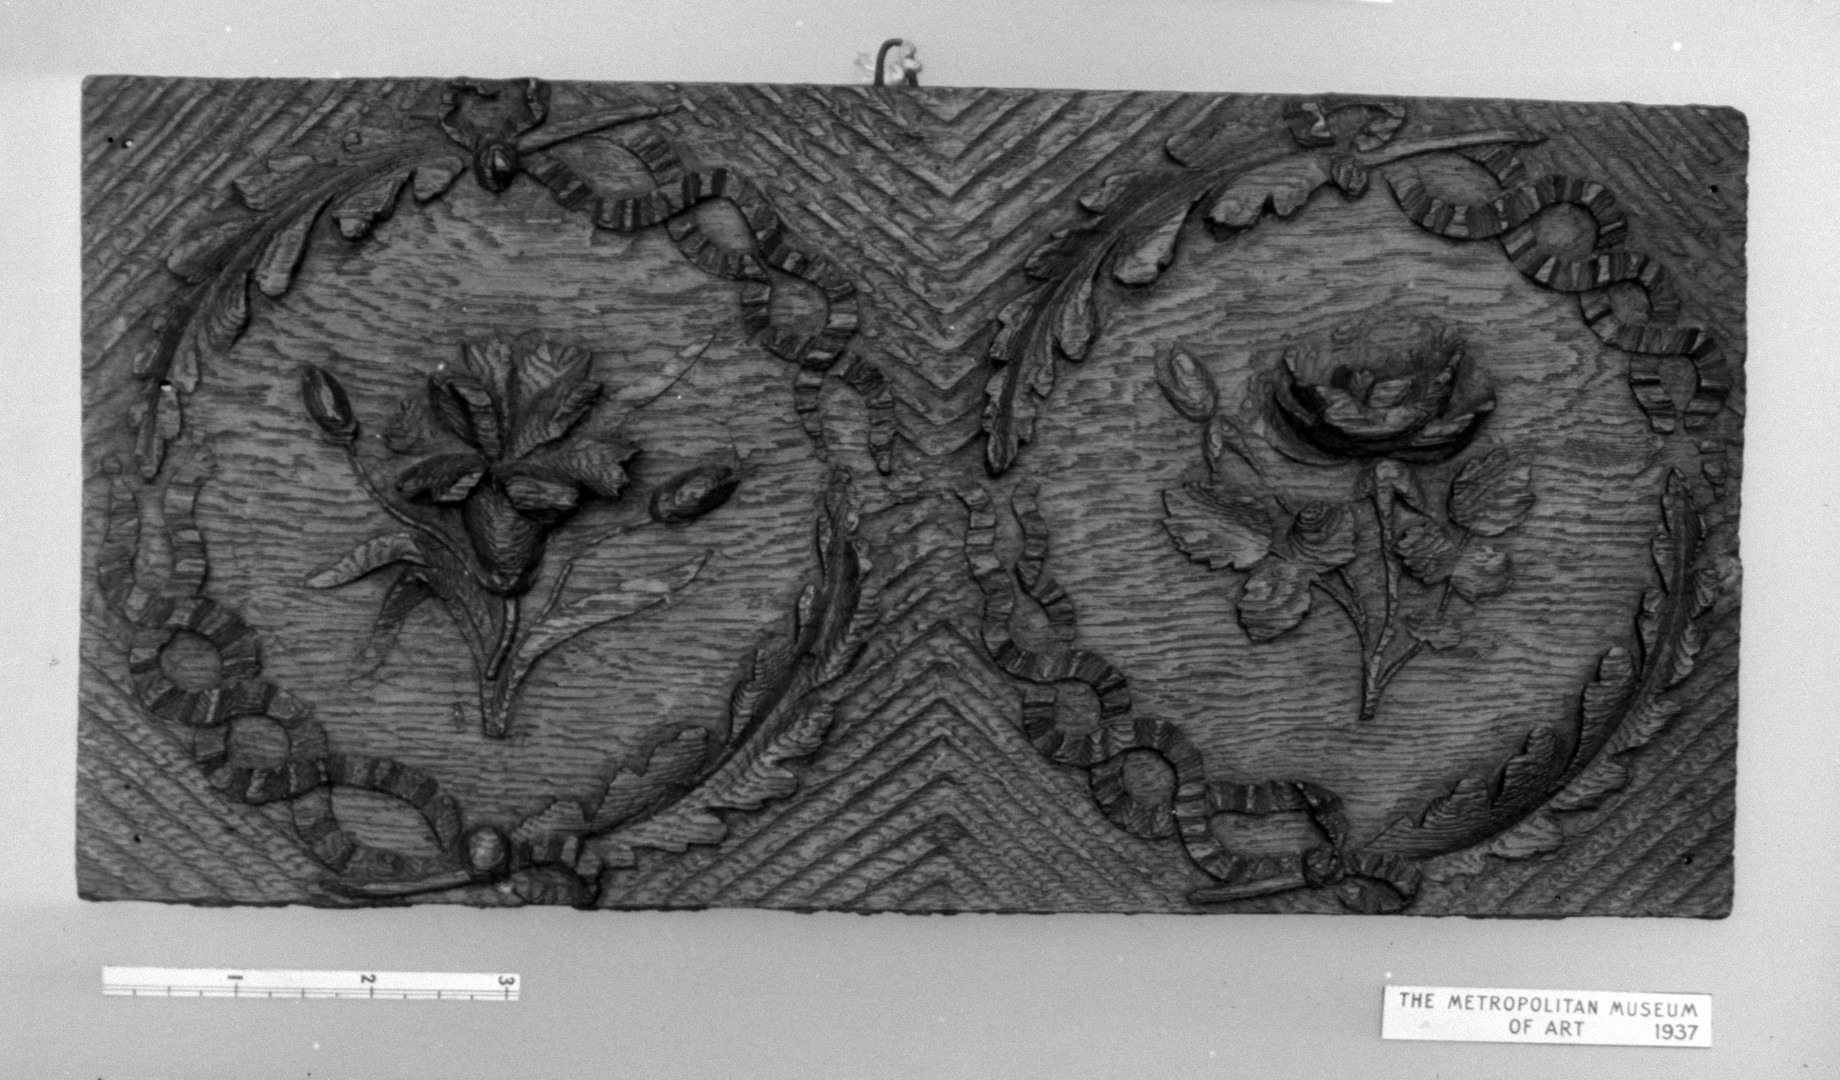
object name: panel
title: Panel (part of a set)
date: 1701-1800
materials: wood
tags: flowers